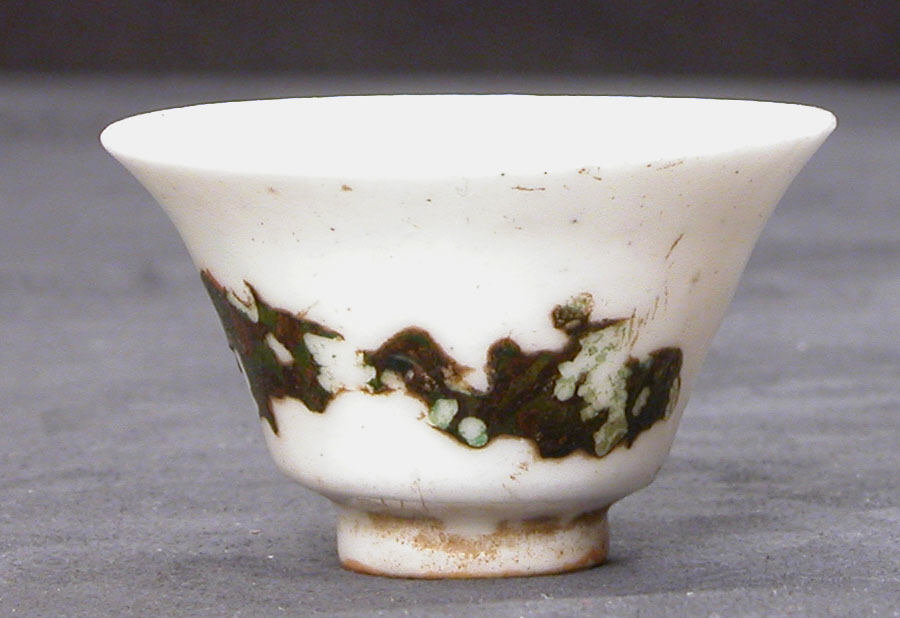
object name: cup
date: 1701-1800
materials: stonepaste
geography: iran